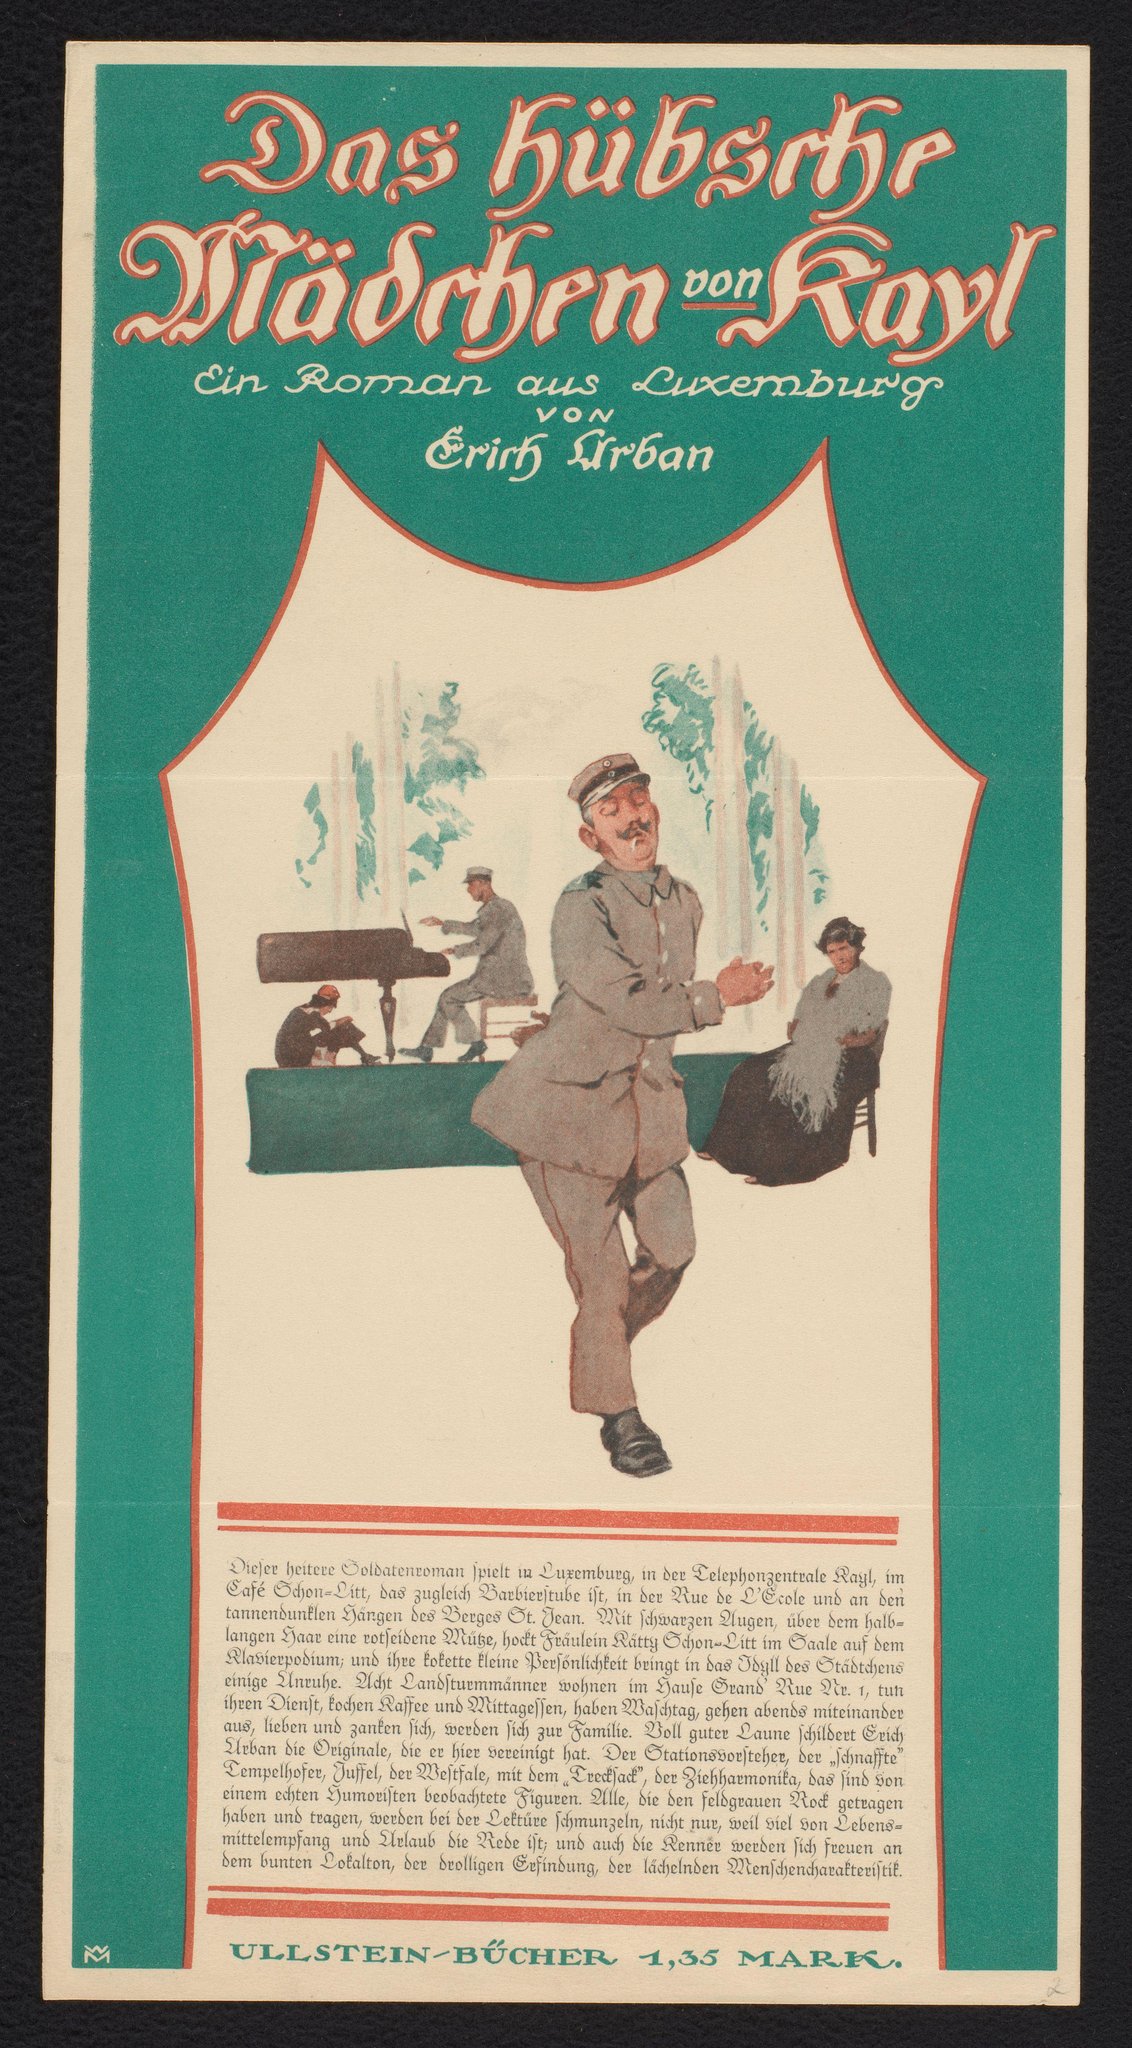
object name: print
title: Reclamebiljet voor: Erich Urban, Das hübsche Mädchen von Kayl, ein Roman aus Luxemburg, [1918]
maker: Anonymous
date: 1918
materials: paper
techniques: lithograph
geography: berlin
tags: grand piano, man dancing alone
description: Dansende man in uniform met daarachter op een podium een pianist en een vrouw onder de piano. Een tweede vrouw op een stoel bij het podium.